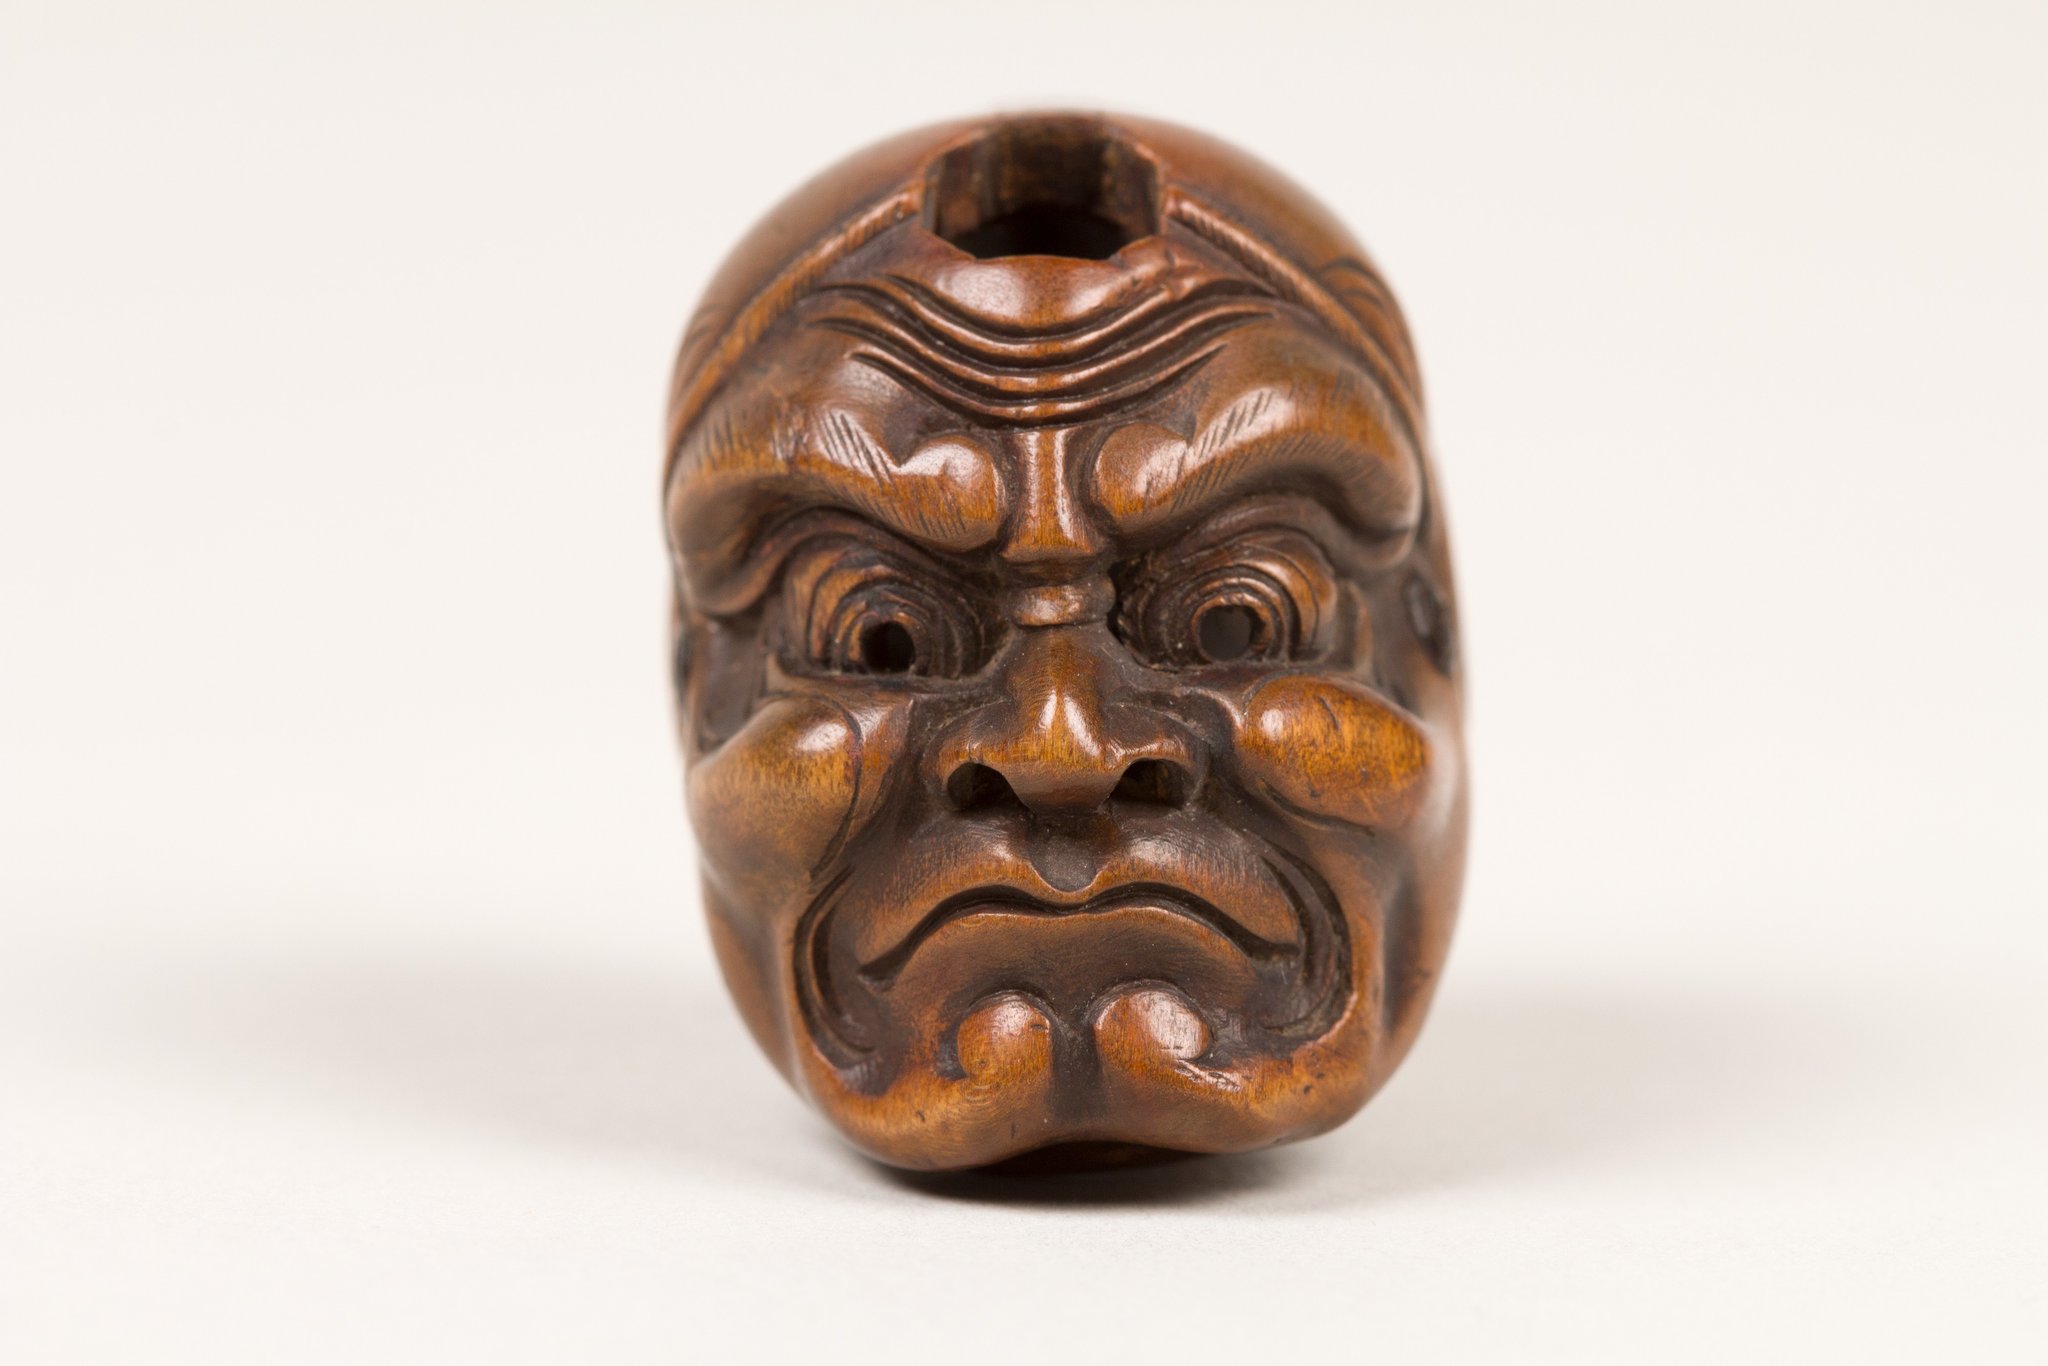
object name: netsuke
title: Netsuke of Double Mask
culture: japanese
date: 1801-1900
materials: wood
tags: masks